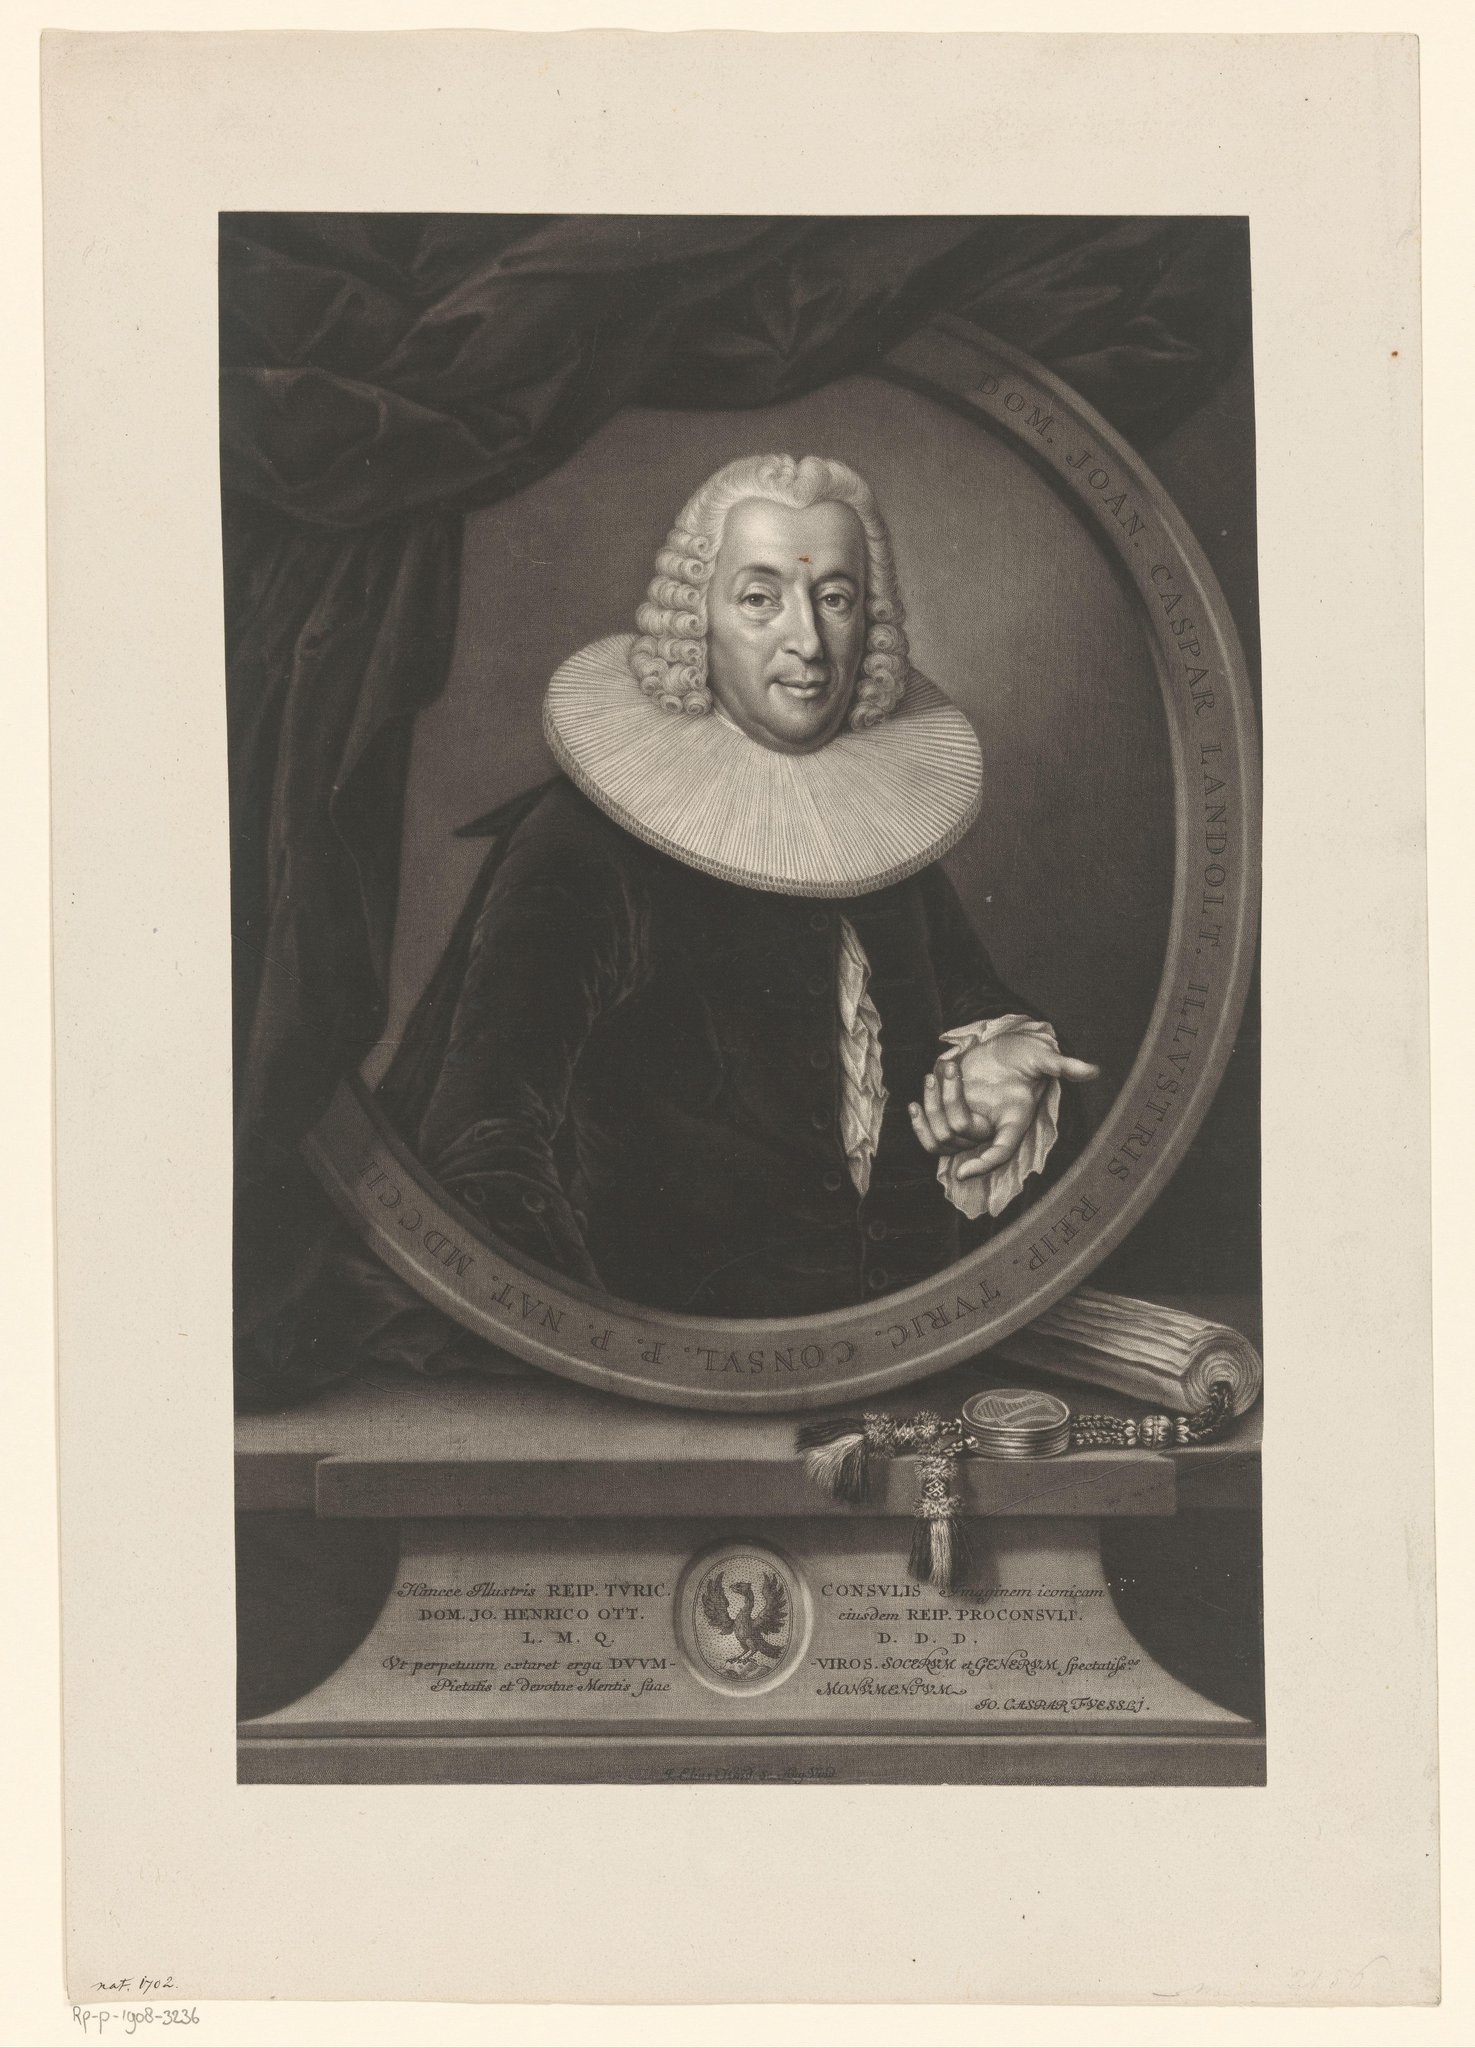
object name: print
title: Portret van Hans Caspar Landolt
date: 1749-1781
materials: paper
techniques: mezzotint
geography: augsburg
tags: mayor, mayor, burgomaster, historical persons, seal, stamp, scroll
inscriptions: collector's mark: Lugt 2228, inscription: ‘Amann’ Lugt 9